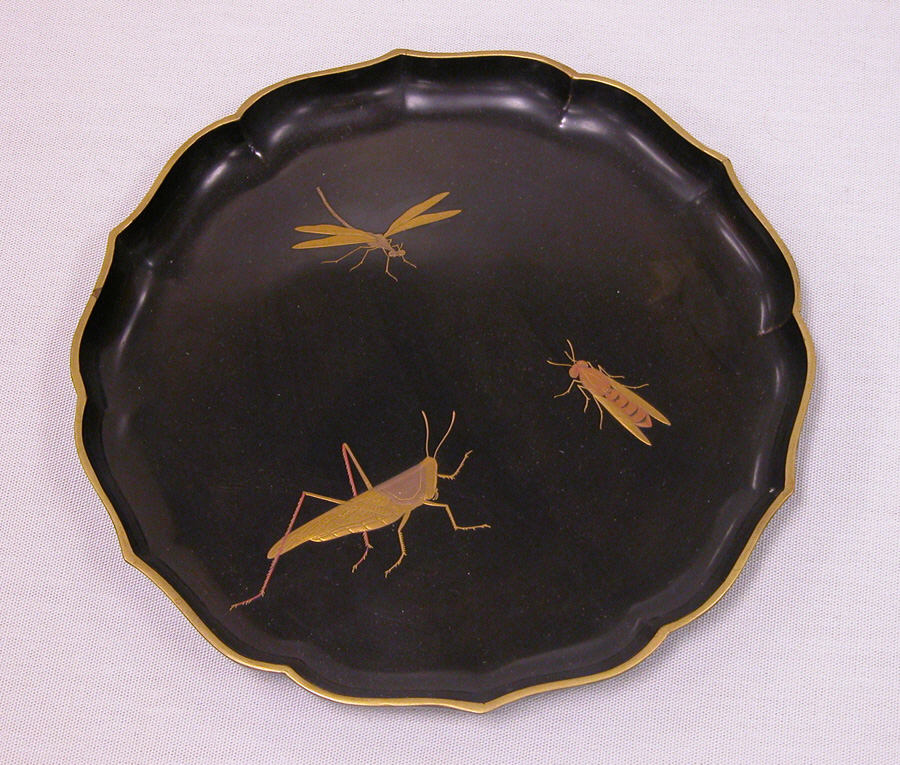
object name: tray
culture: japanese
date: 1801-1900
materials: gold, lacquer, silver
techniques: hiramakie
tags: dragonflies